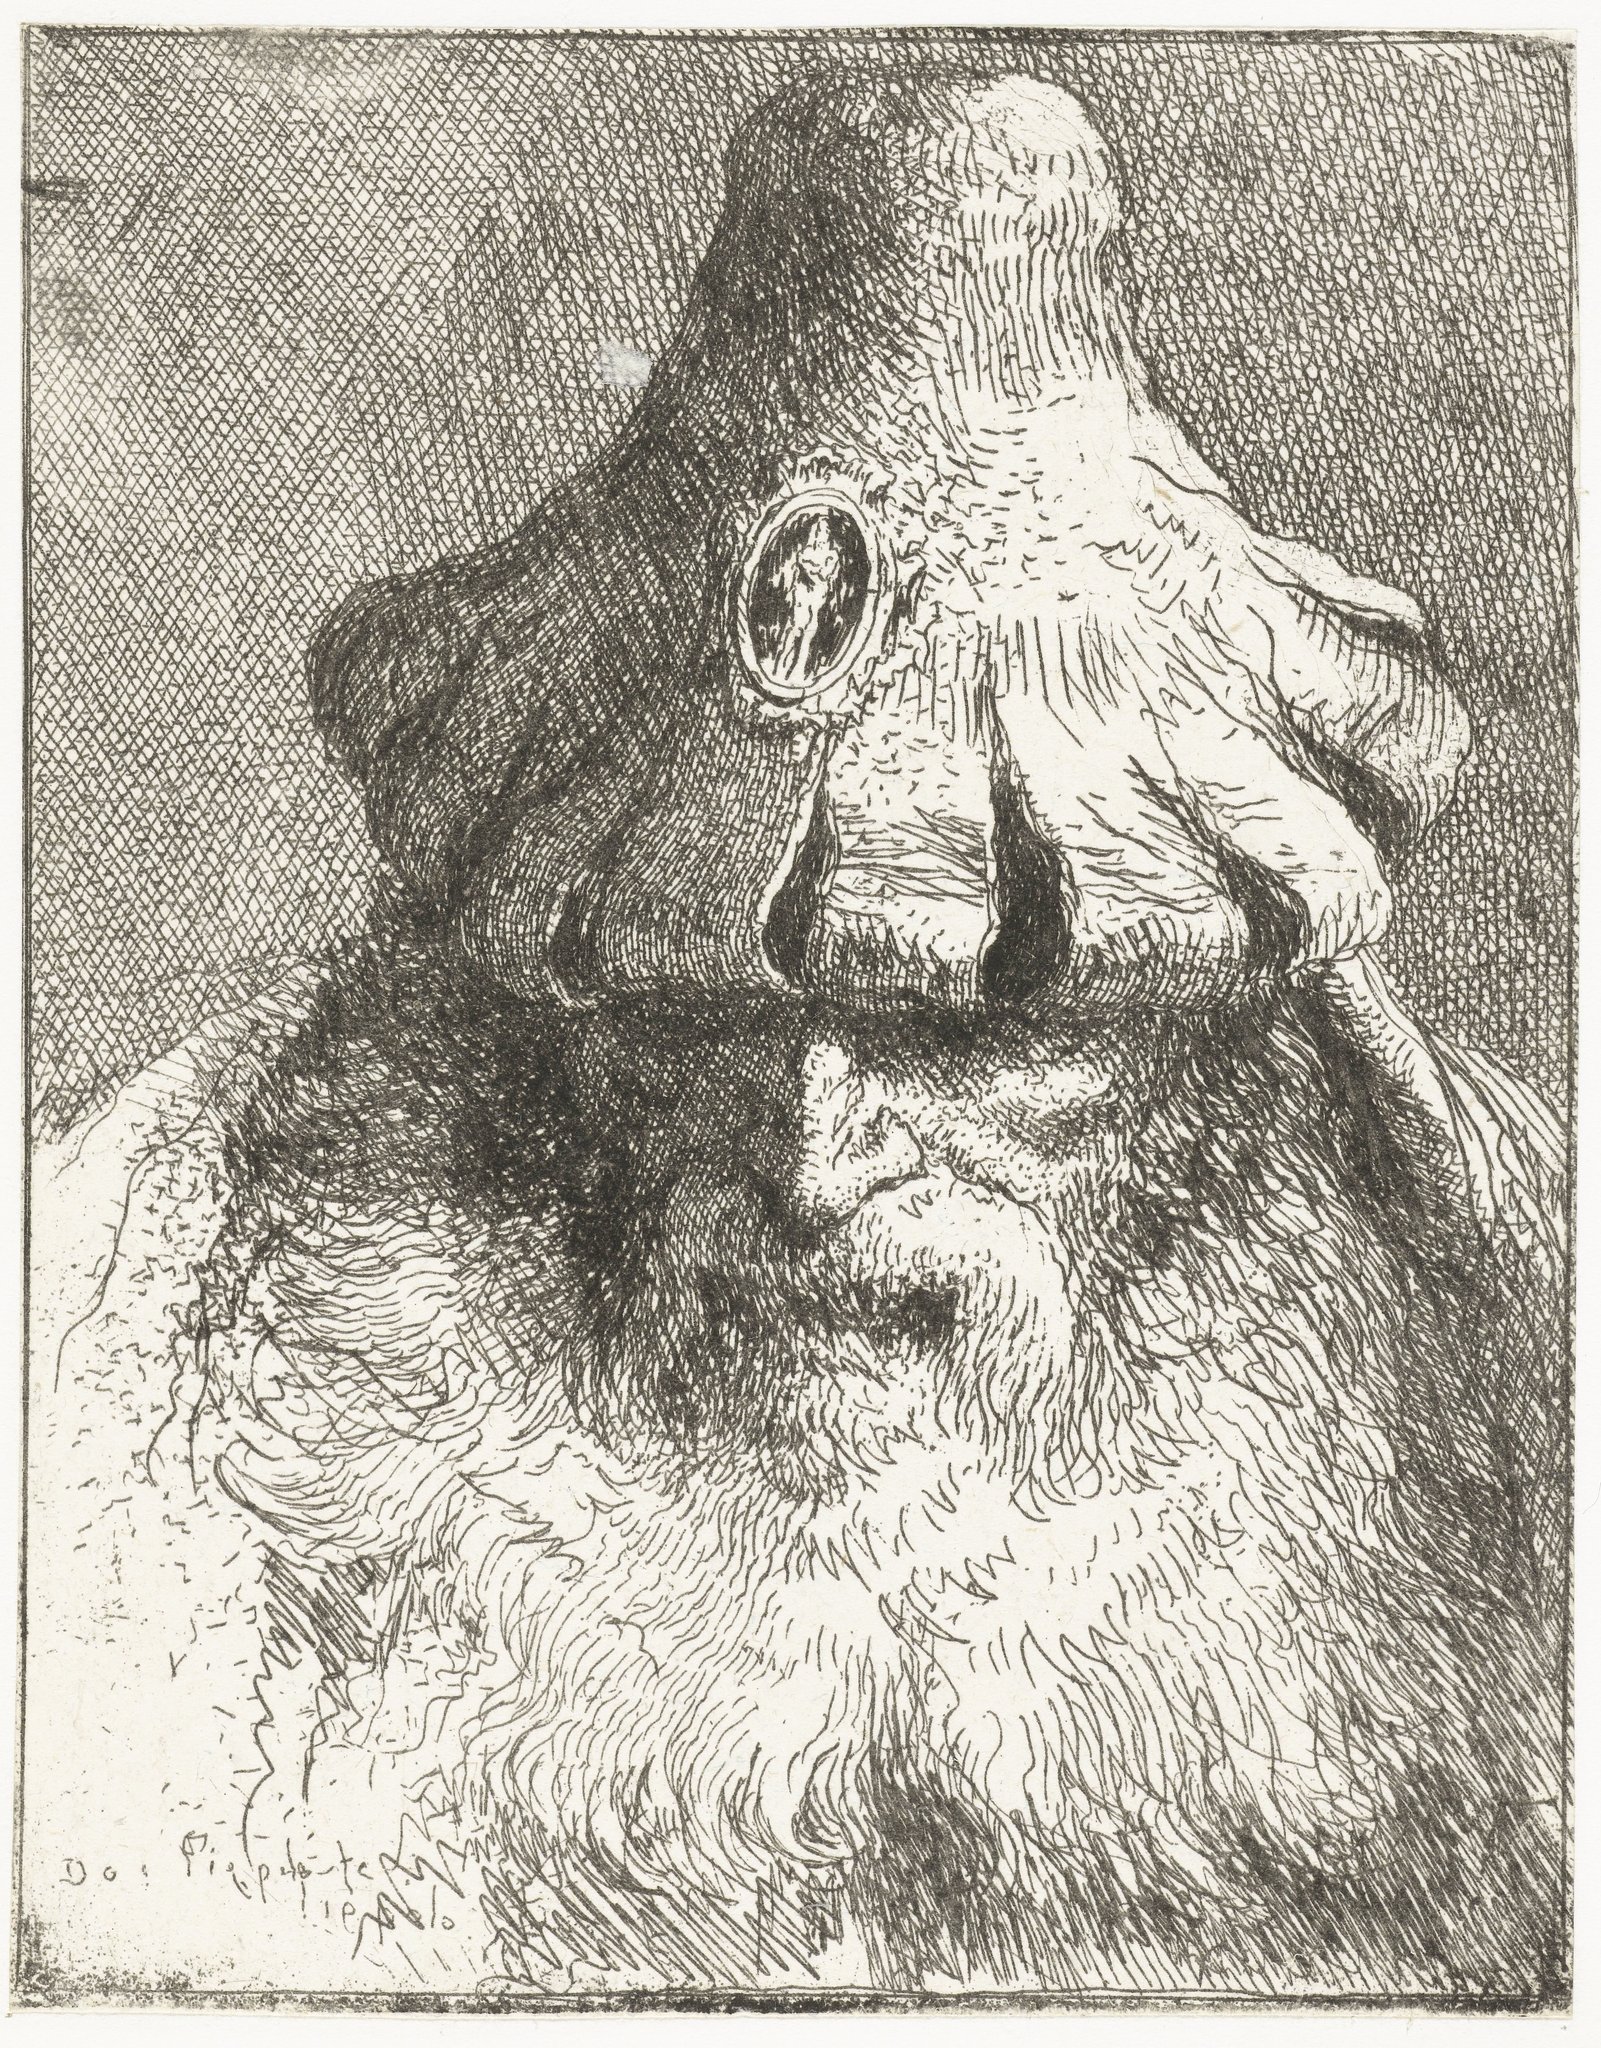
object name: print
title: Oude man met kegelvormige muts met ingesneden rand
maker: giovanni domenico tiepolo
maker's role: draughtsman, print maker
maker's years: 1727-1804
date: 1757-1758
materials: paper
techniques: etching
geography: venice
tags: head-gear: cap (+ men's clothes), person with big beard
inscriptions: collector's mark: Lugt 2228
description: Prent uit serie Verzameling hoofden (Raccolta di teste). Giovanni Domenico Tiepolo vervaardigde in de winter van 1757-1758 en in de periode van 1771-1774 deze hoofden naar schilderijen en tekeningen van Giovanni Battista Tiepolo. De eerste uitgave verscheen in 1774 in twee delen met elk dertig prenten. Deze prent werd in de tweede staat met serienummer 24 opgenomen in deel 2.